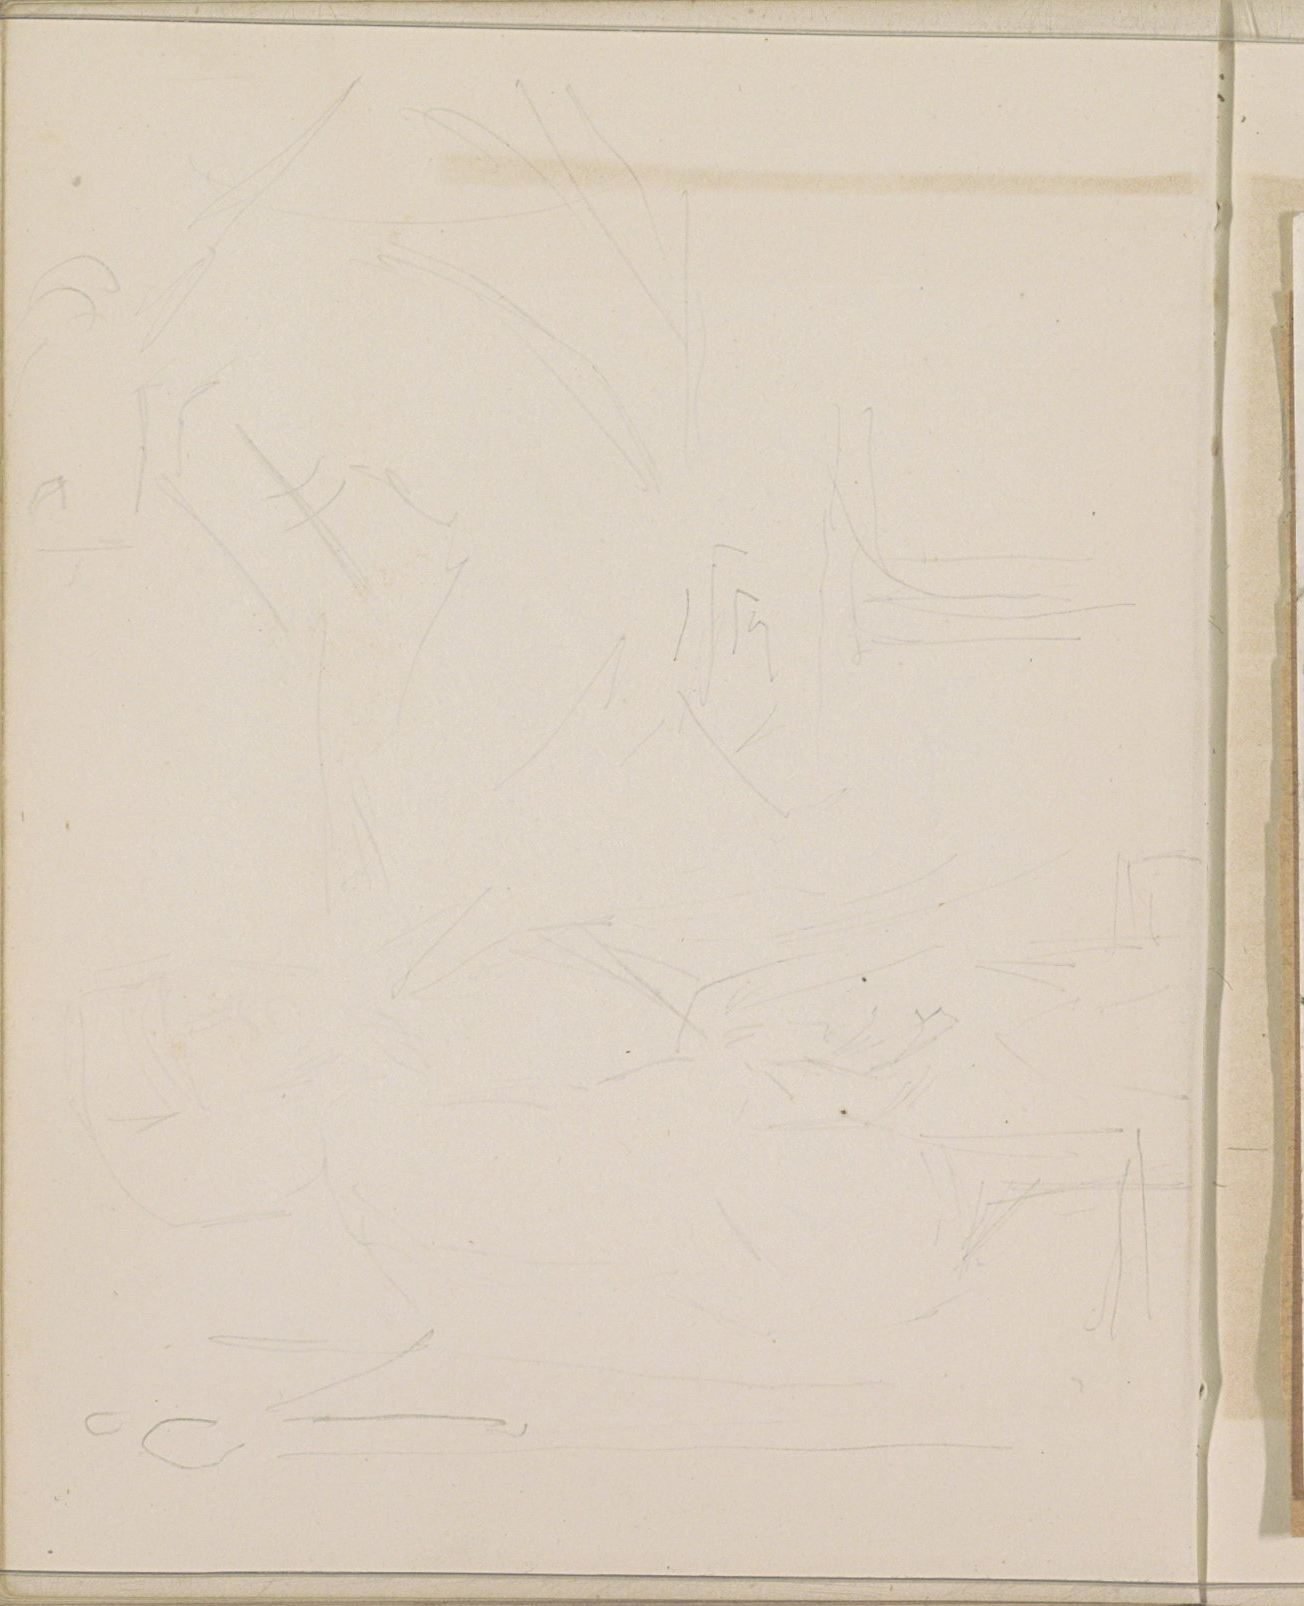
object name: sketchbook leaf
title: Liggende naakte vrouw en een geklede knielende vrouw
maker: reijer stolk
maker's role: draughtsman, print maker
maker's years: 1896-1945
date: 1916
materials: paper, pencil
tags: kneeling figure - aa - female human figure, lying figure - aa - female human figure (+ nude human being)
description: De geklede vrouw draagt mogelijk een habijt. Blad 29 verso uit een schetsboek met 72 bladen.